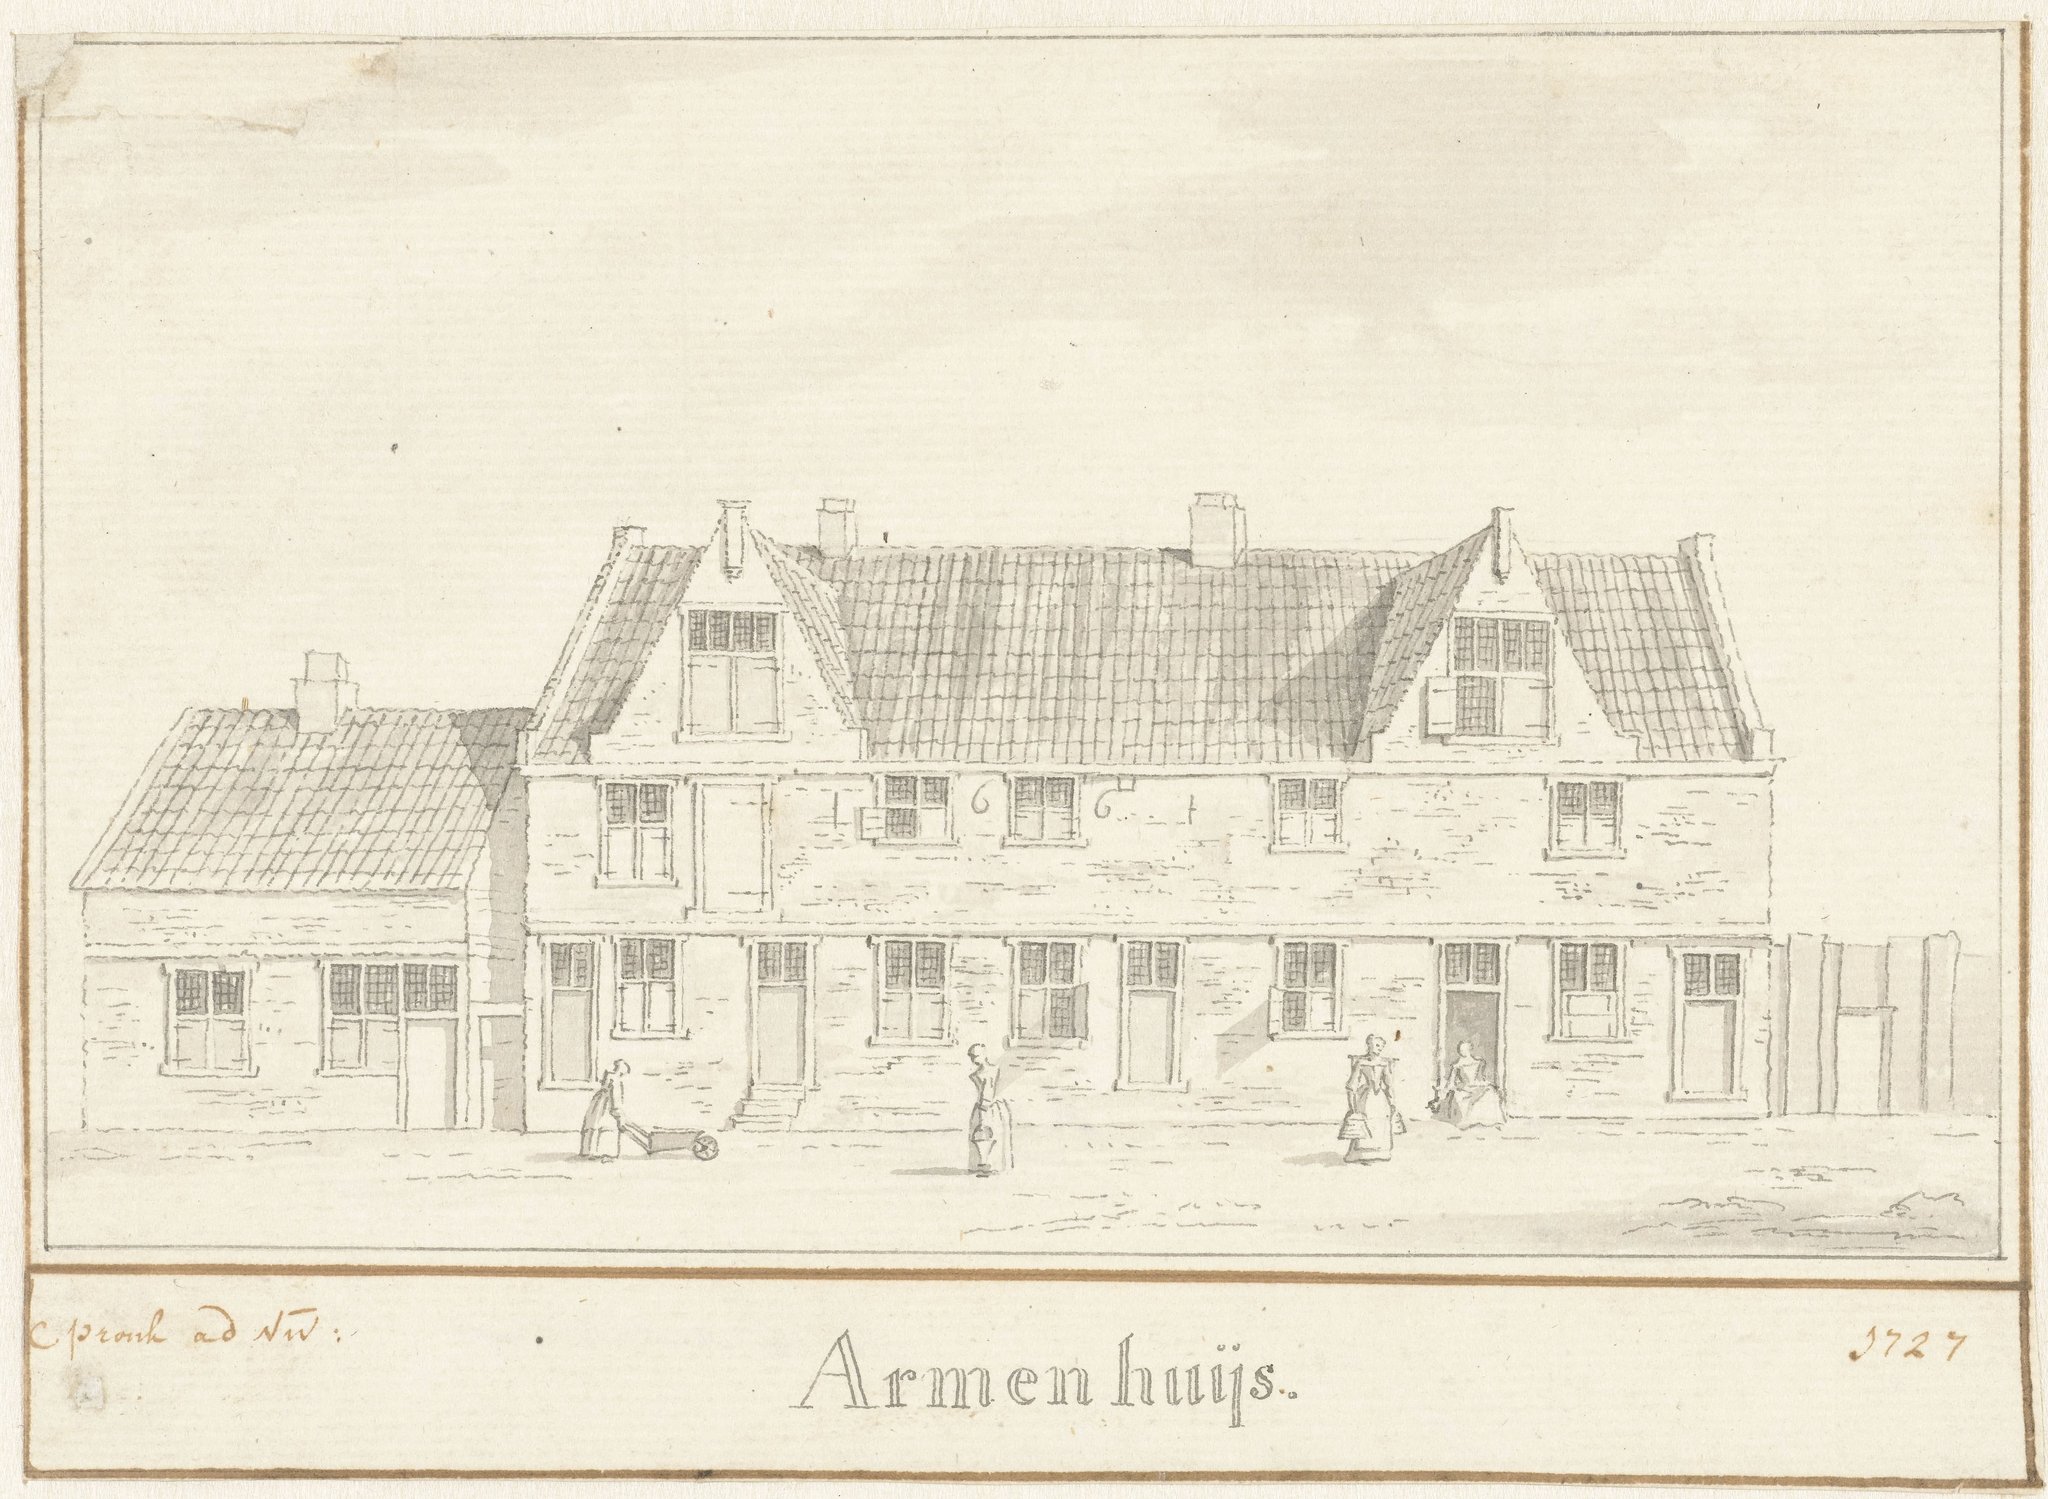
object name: drawing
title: Het armenhuis te Alkmaar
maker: cornelis pronk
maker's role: draughtsman, painter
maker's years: 1691-1759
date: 1727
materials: ink, paper, pencil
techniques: brush, pen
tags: public welfare